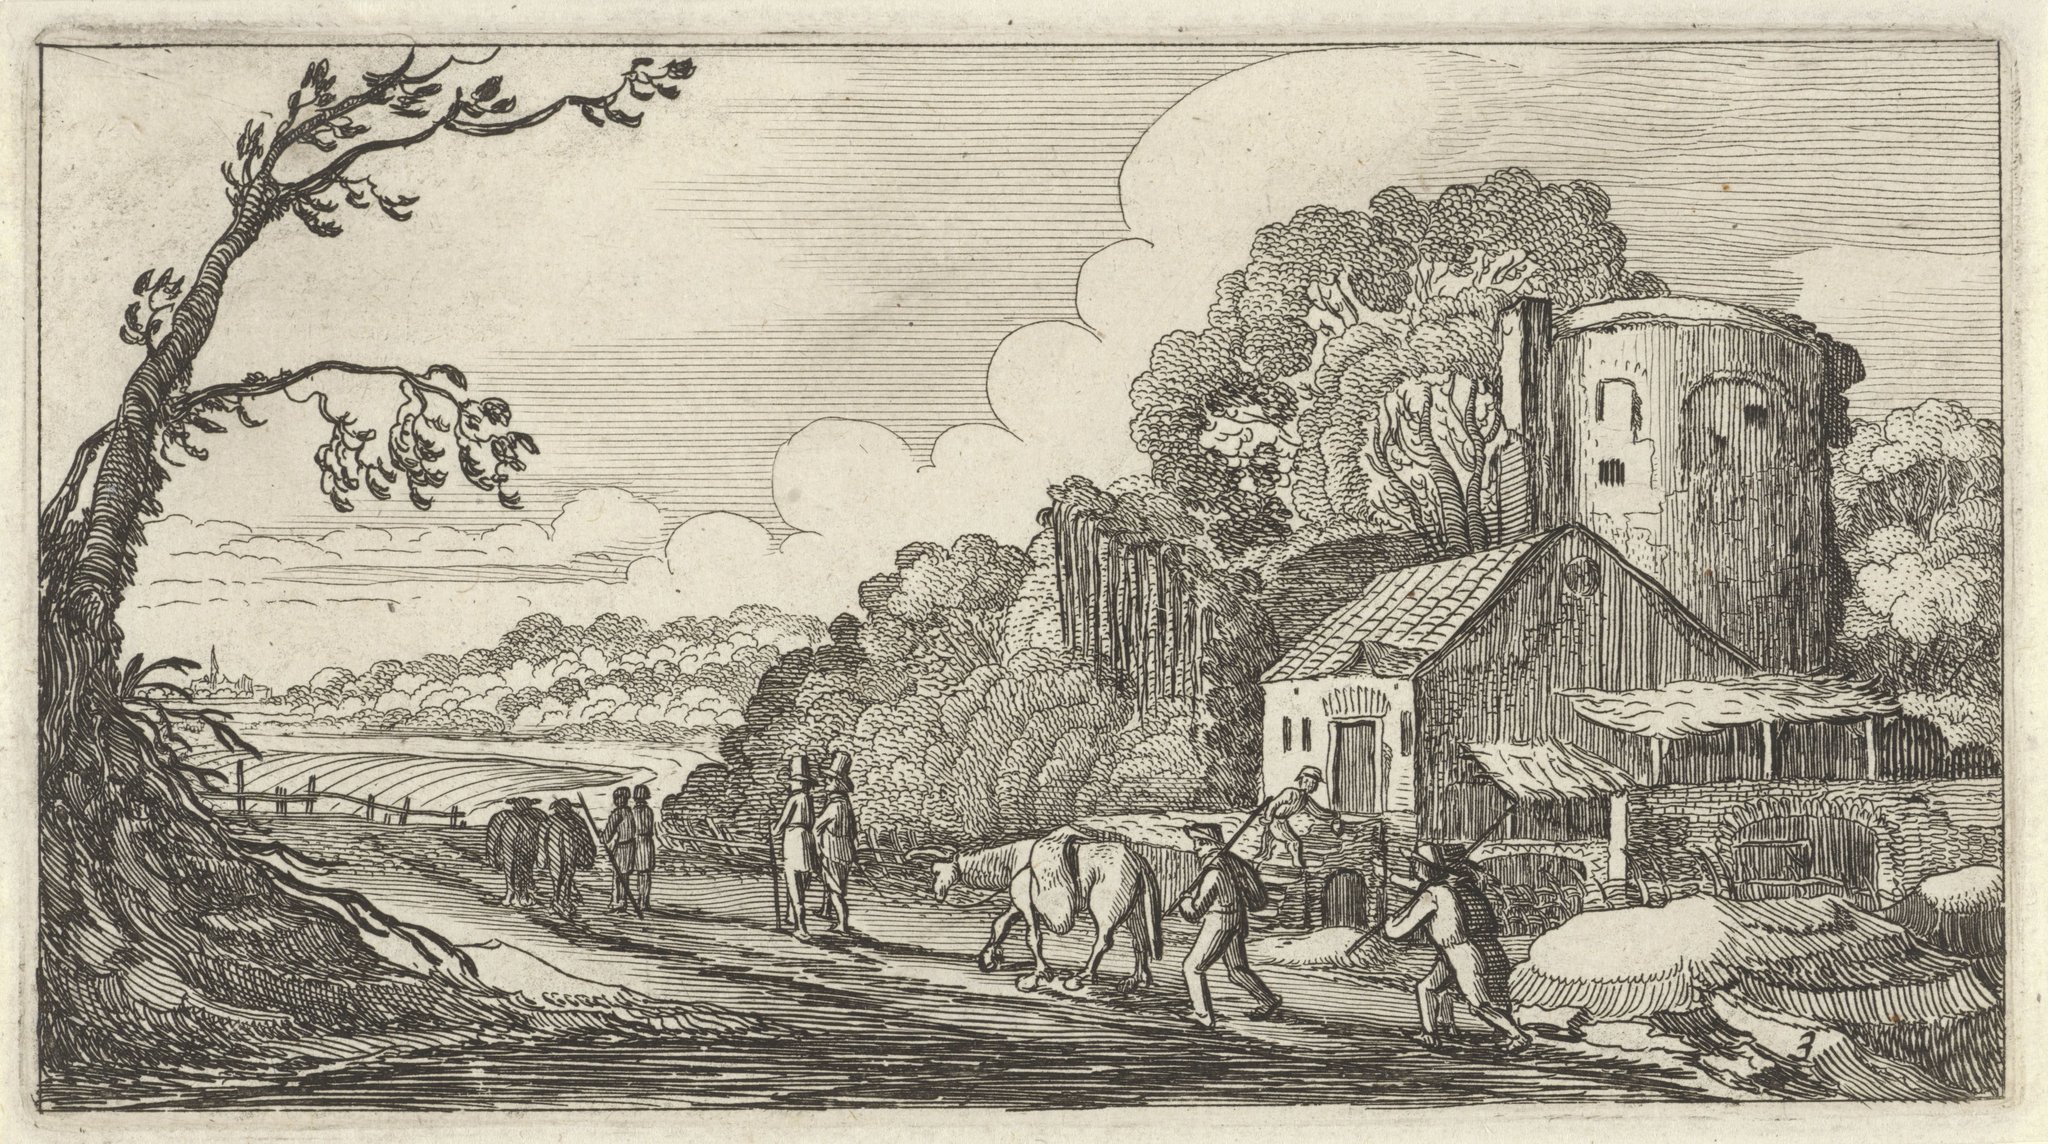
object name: print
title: Landschap met reizigers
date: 1624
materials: paper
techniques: etching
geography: amsterdam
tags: riding a horse, ass, or mule; rider, horseman, 'en route', traveller under way, farm (building)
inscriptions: collector's mark: Lugt 2228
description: Gezicht op een vlak landschap met reizigers die langs een boerderij met een toren trekken. De prent maakt deel uit van een serie met twaalf landschappen met figuren.